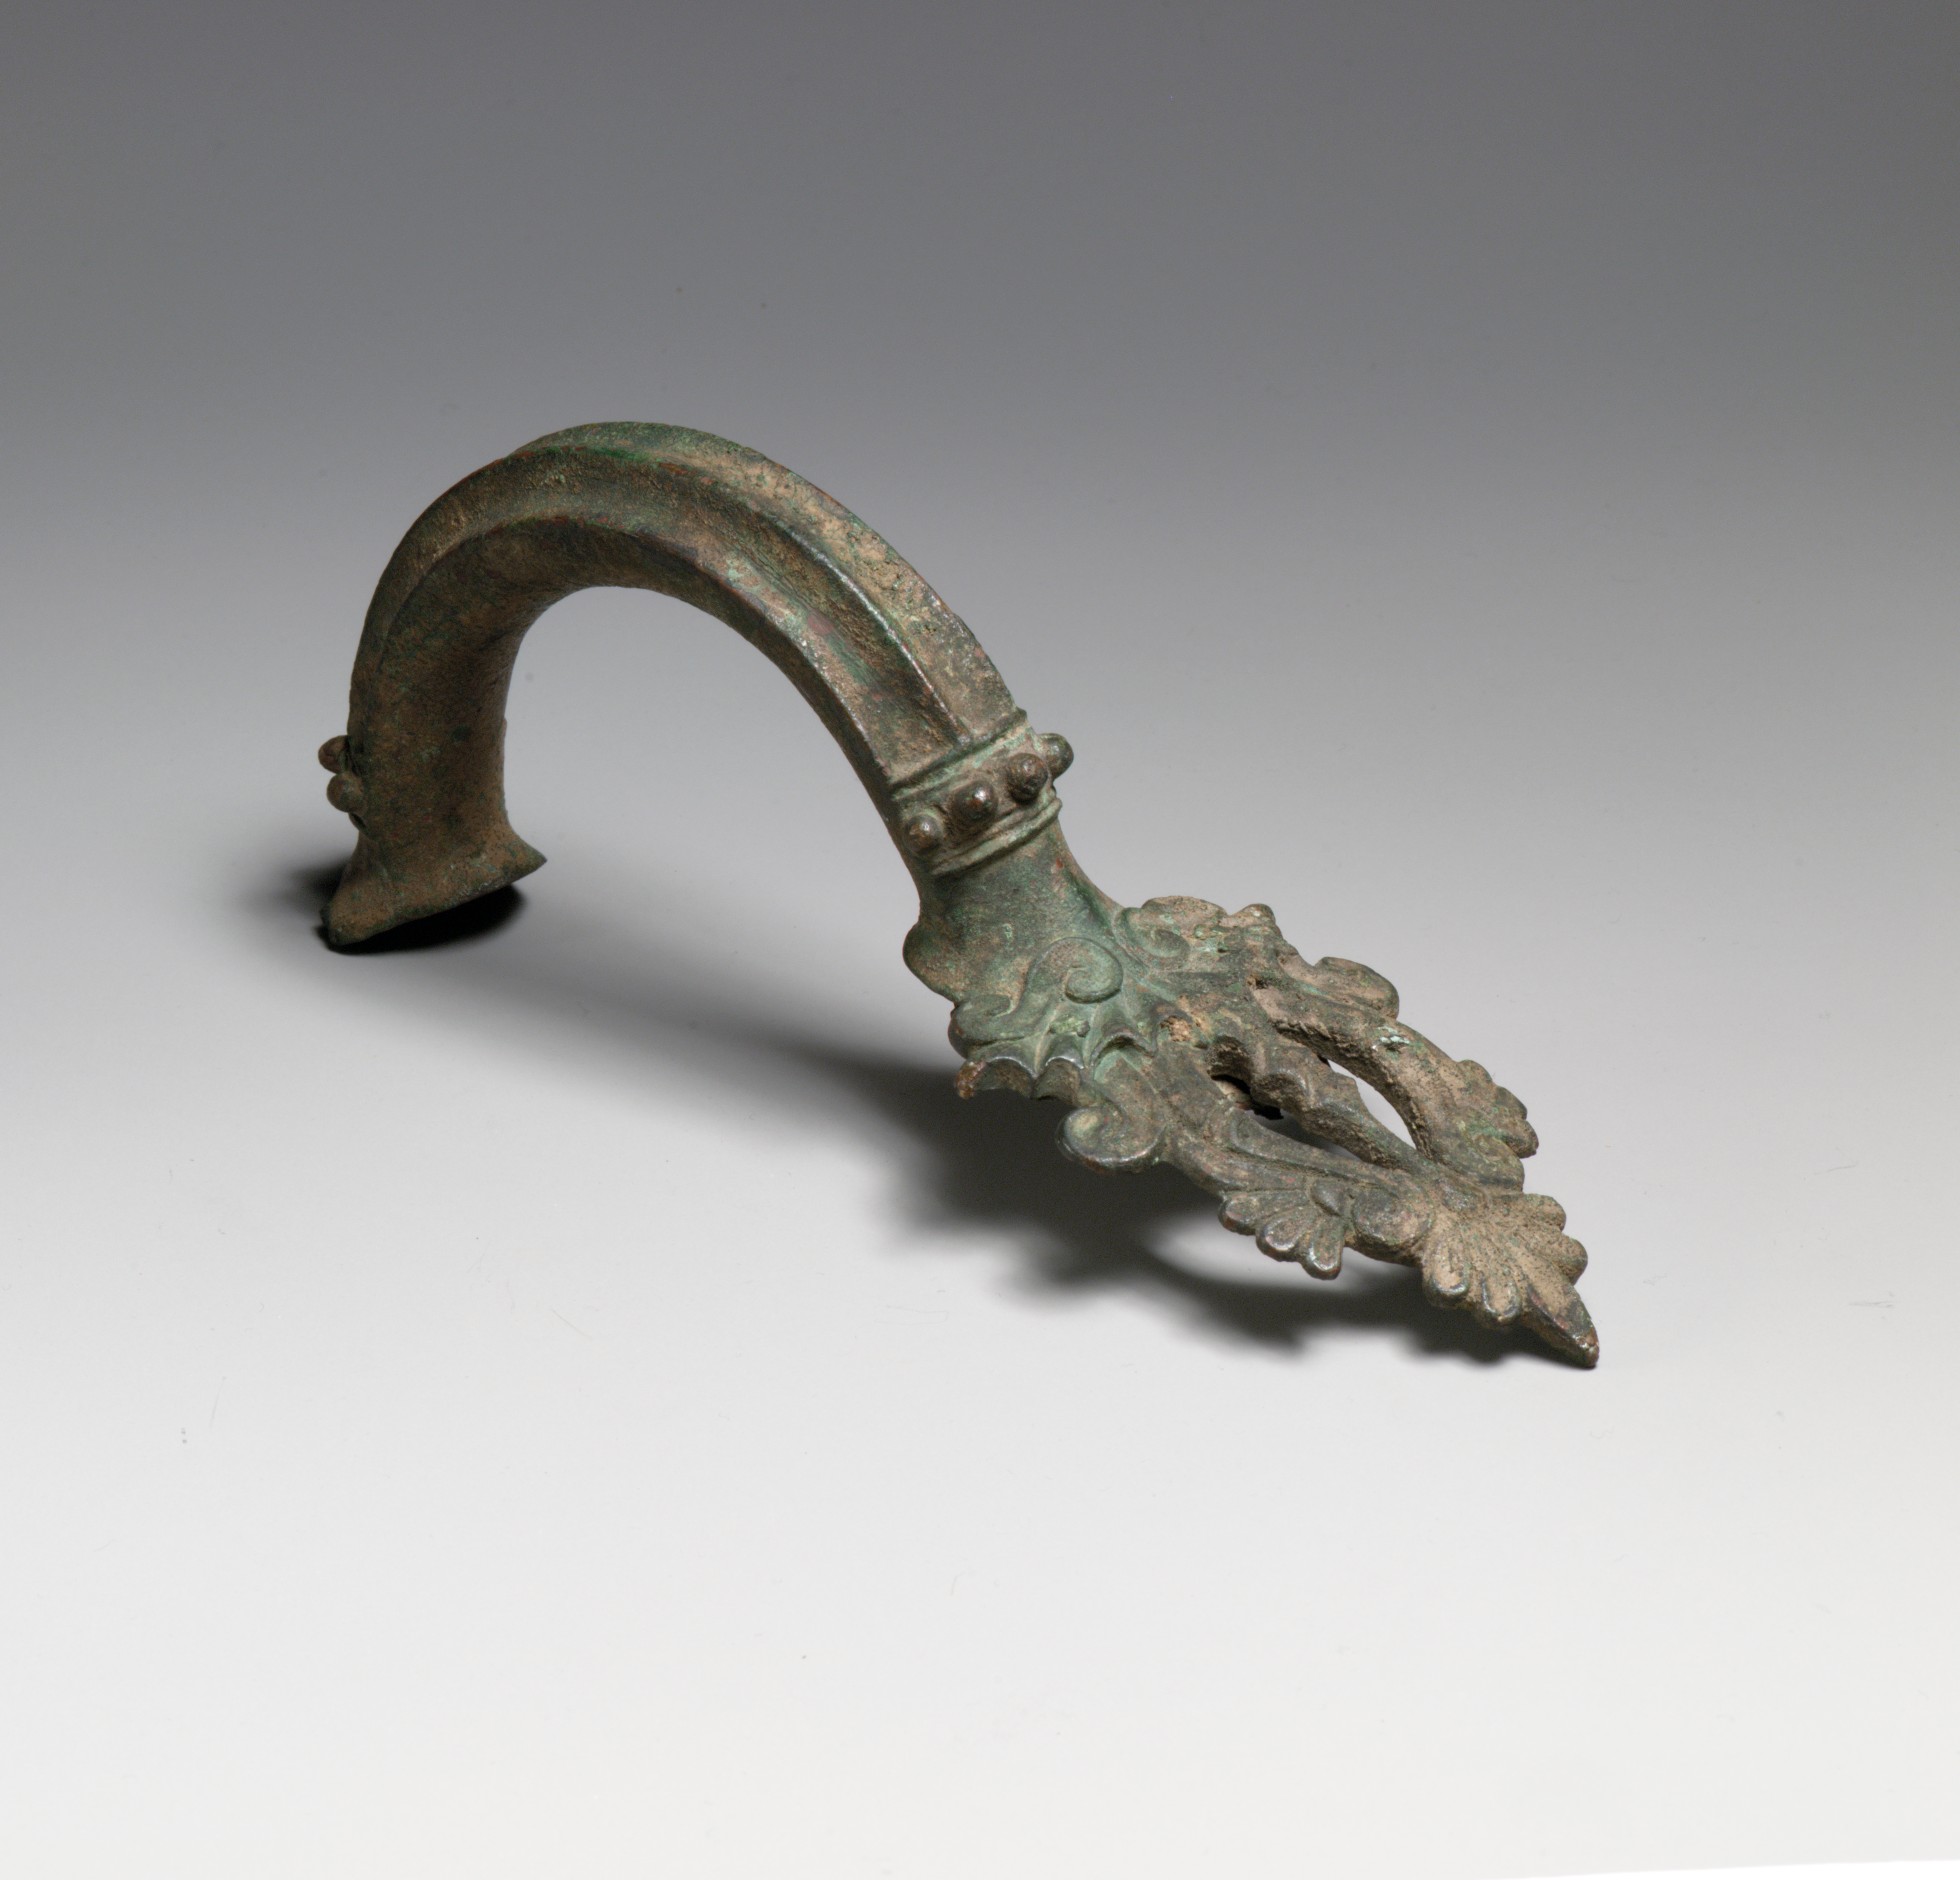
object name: handle of a hydria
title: Bronze handle of a hydria (water jar)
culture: greek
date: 400-301 BCE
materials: bronze